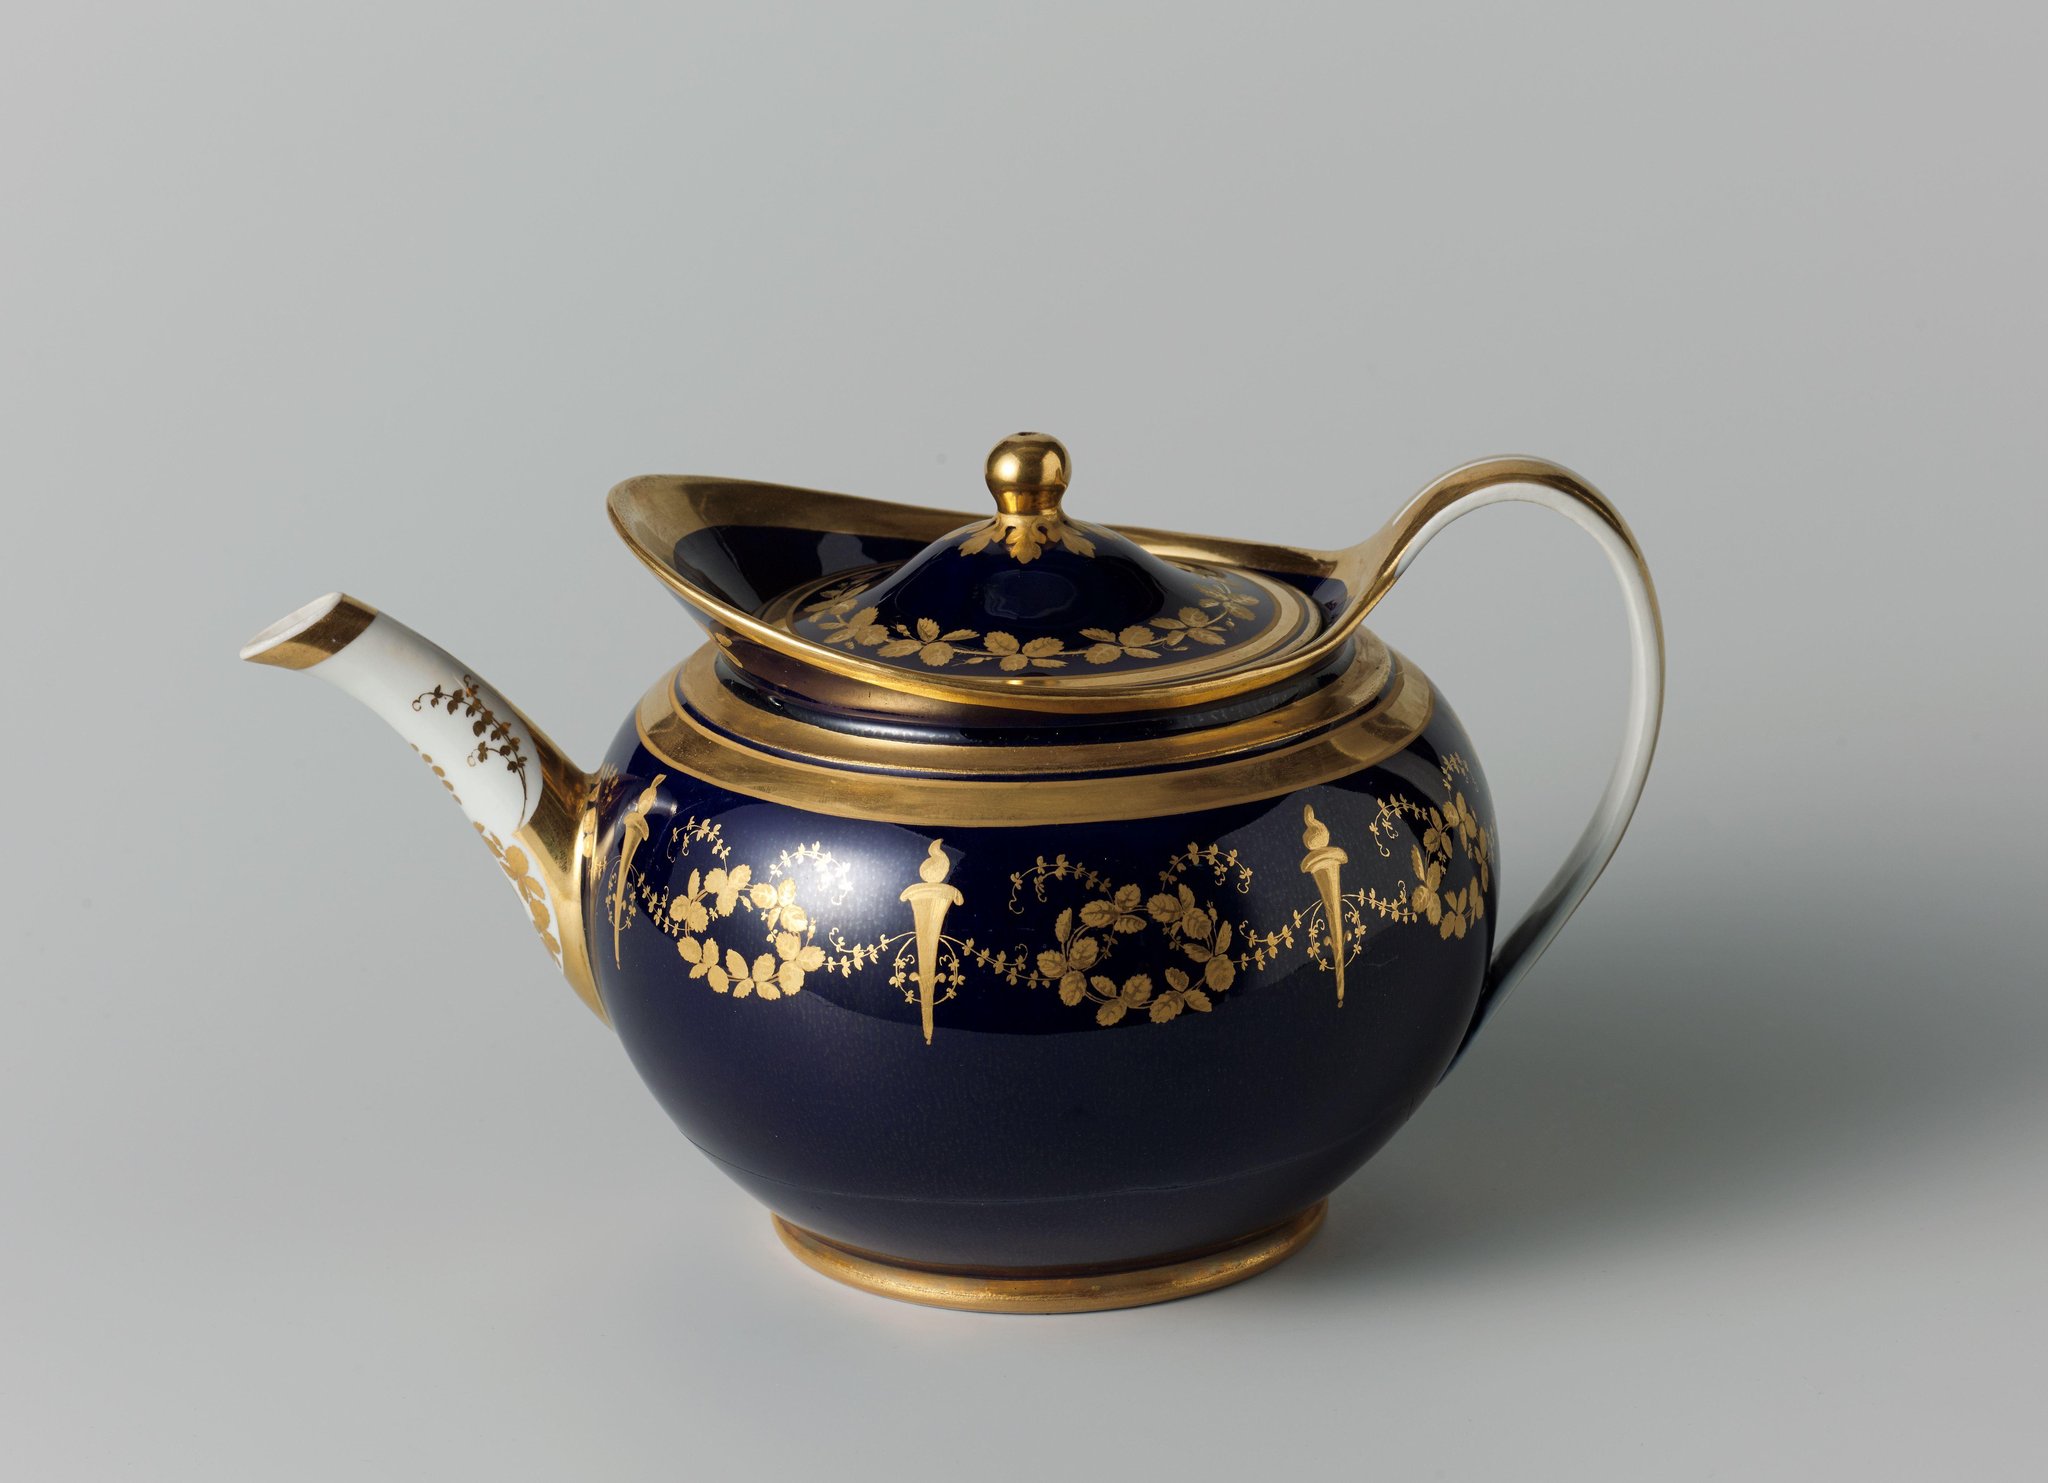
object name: teapot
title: Teapot with foliate scrolls and torches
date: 1821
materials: cobalt, glaze, gold, paint, porcelain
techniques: firing, forming, gilding, turning, vitrification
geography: vienna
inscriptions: mark: ‘schild/ ii/ 25/ 821’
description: Theepot van porselein met een gedrukt, bolvormig lichaam, licht gebogen tuit en hoog oor vanuit de rand, beschilderd in onderglazuur blauw en goud. De nek is aan de kant van de tuit iets verhoogd. De buik en nek zijn bedekt met onderglazuur blauw. Op de buik een band van bladranken en fakkels. De voet, schouder, nek, oor en rand met gouden banden. De tuit en het verhoogde deel van de nek met bladranken en een fakkel. Gemerkt op de onderzijde met het schild, ii, nummer 25 en jaarnummer 821.